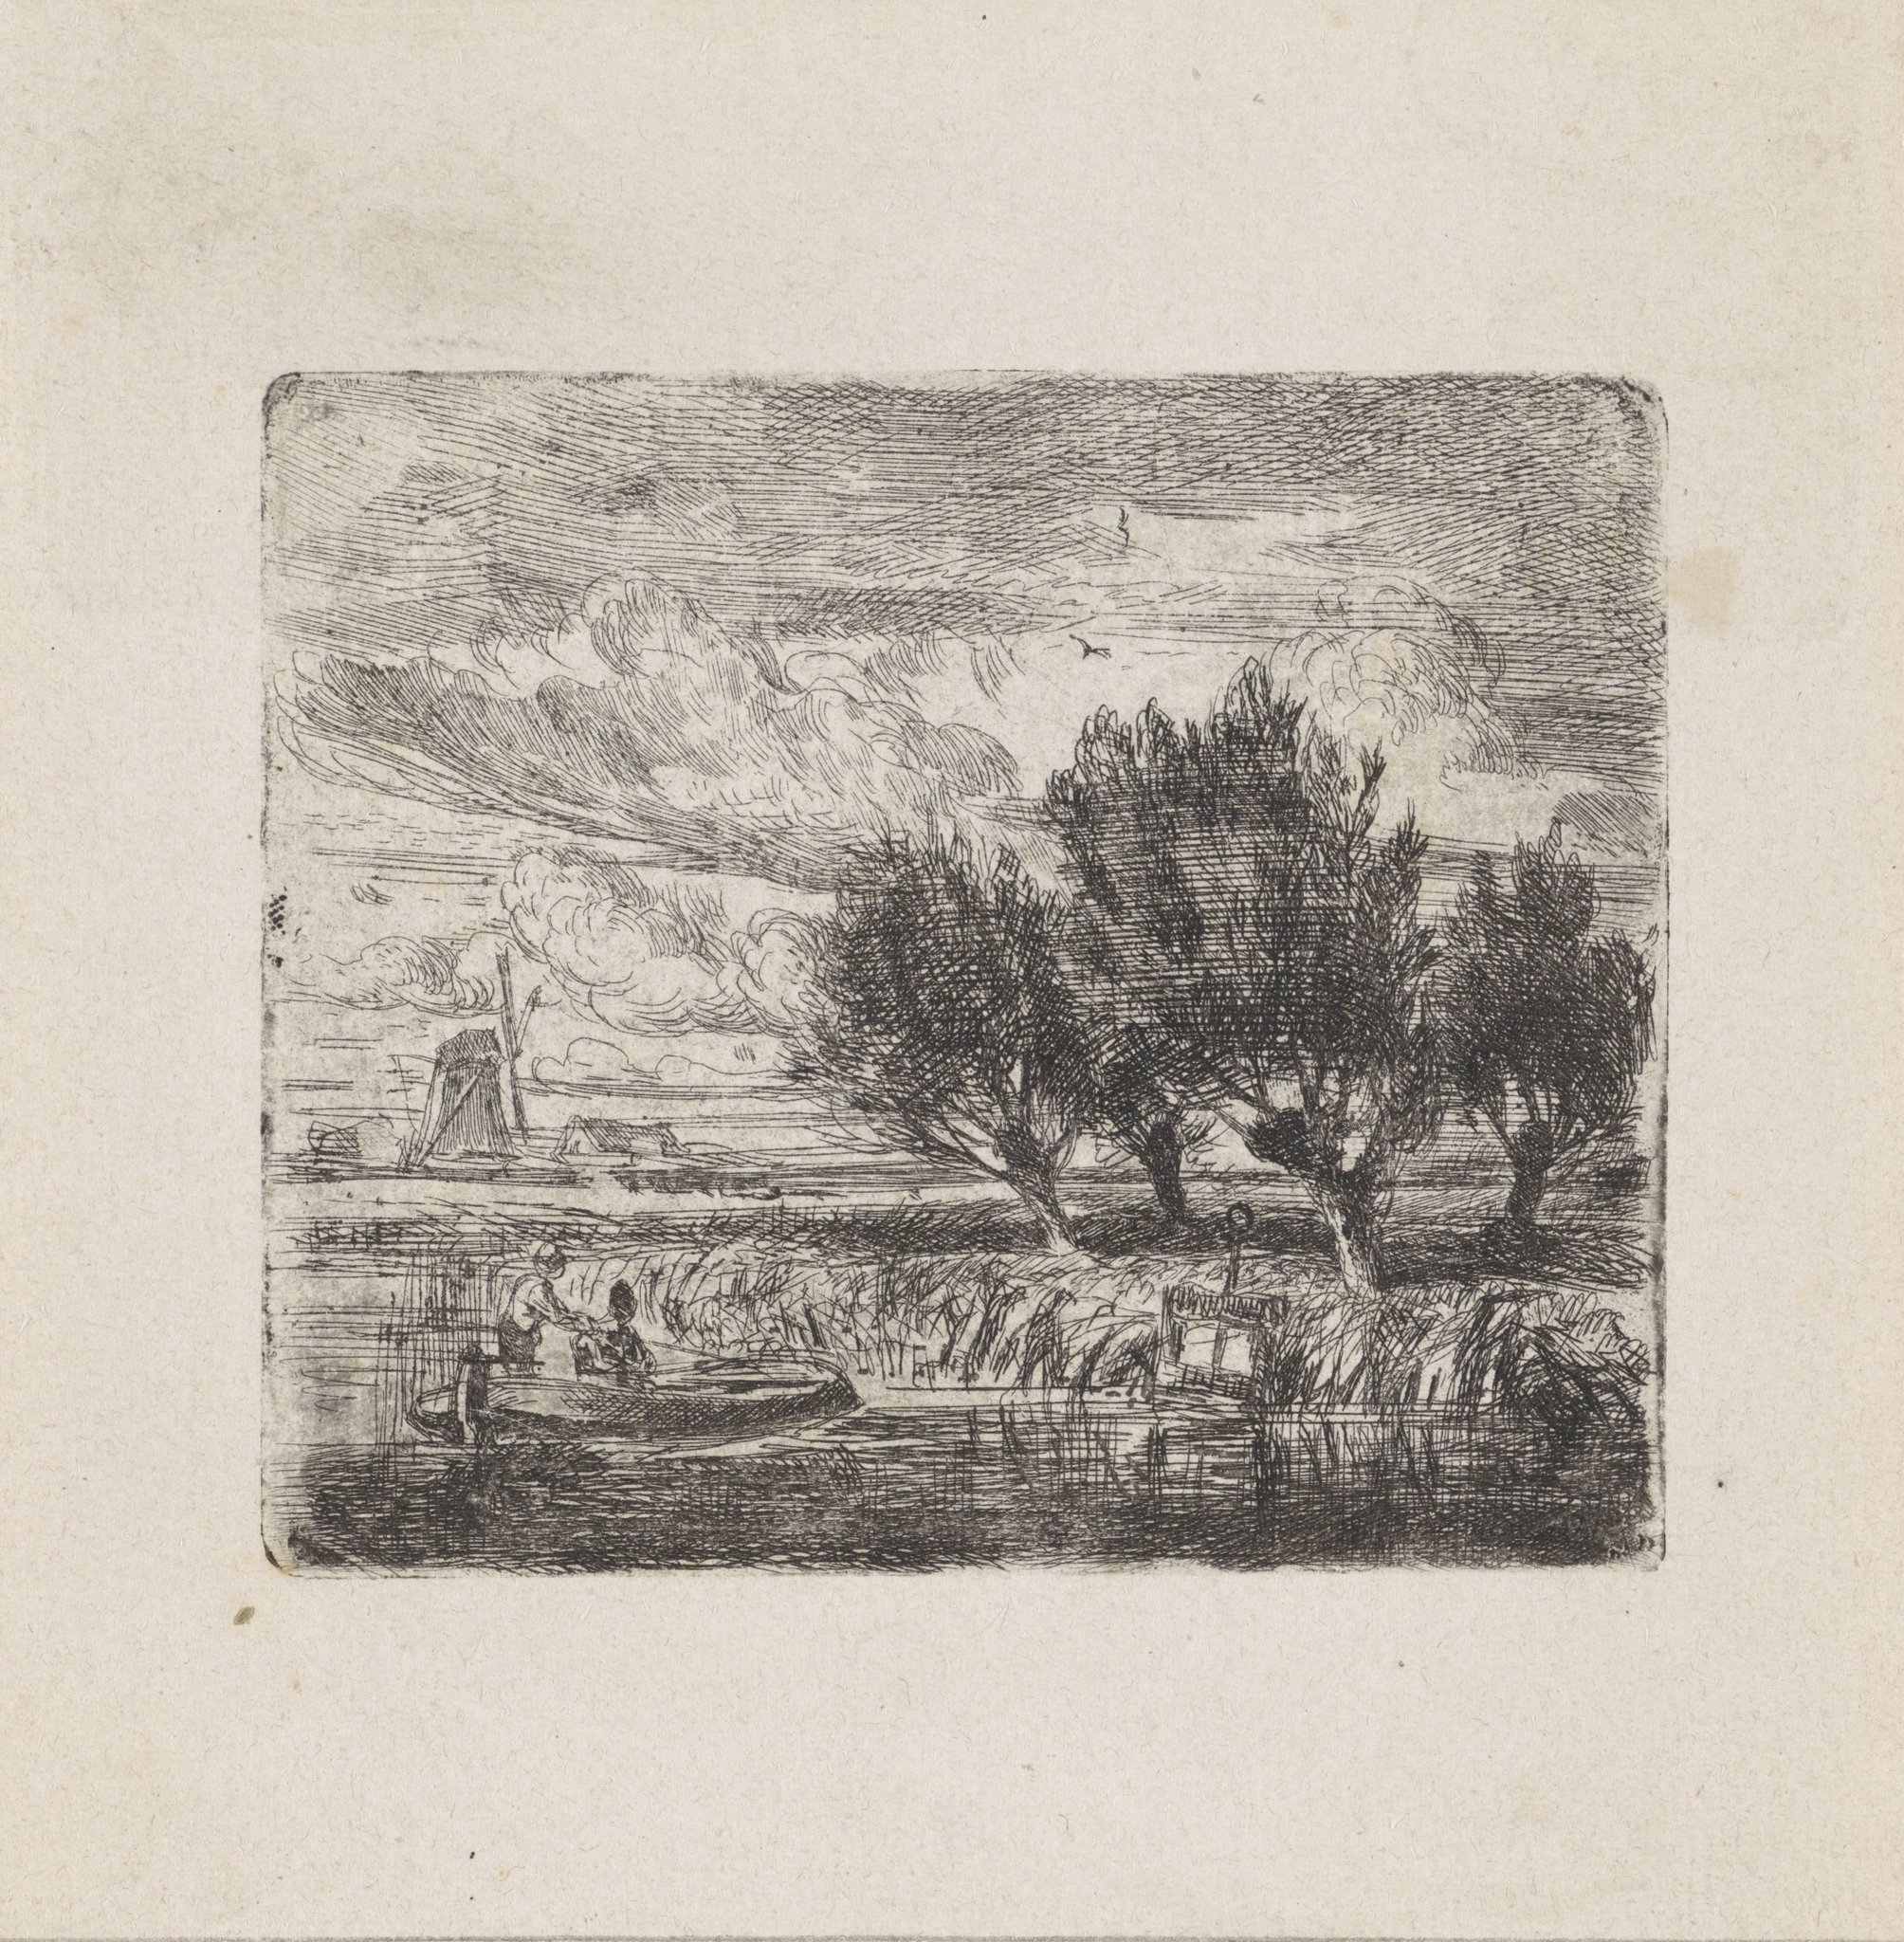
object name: print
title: Knotwilgen aan de waterkant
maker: augustinus jacobus bernardus wouters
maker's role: print maker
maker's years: 1829-1904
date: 1839-1904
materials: paper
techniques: etching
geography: netherlands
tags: rowing-boat, canoe, etc., trees: willow, windmill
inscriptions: collector's mark: Lugt 2228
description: Gezicht over een water waaraan vier knotwilgen staan. Op de voorgrond twee figuren in een sloep en op de achtergrond een molen.